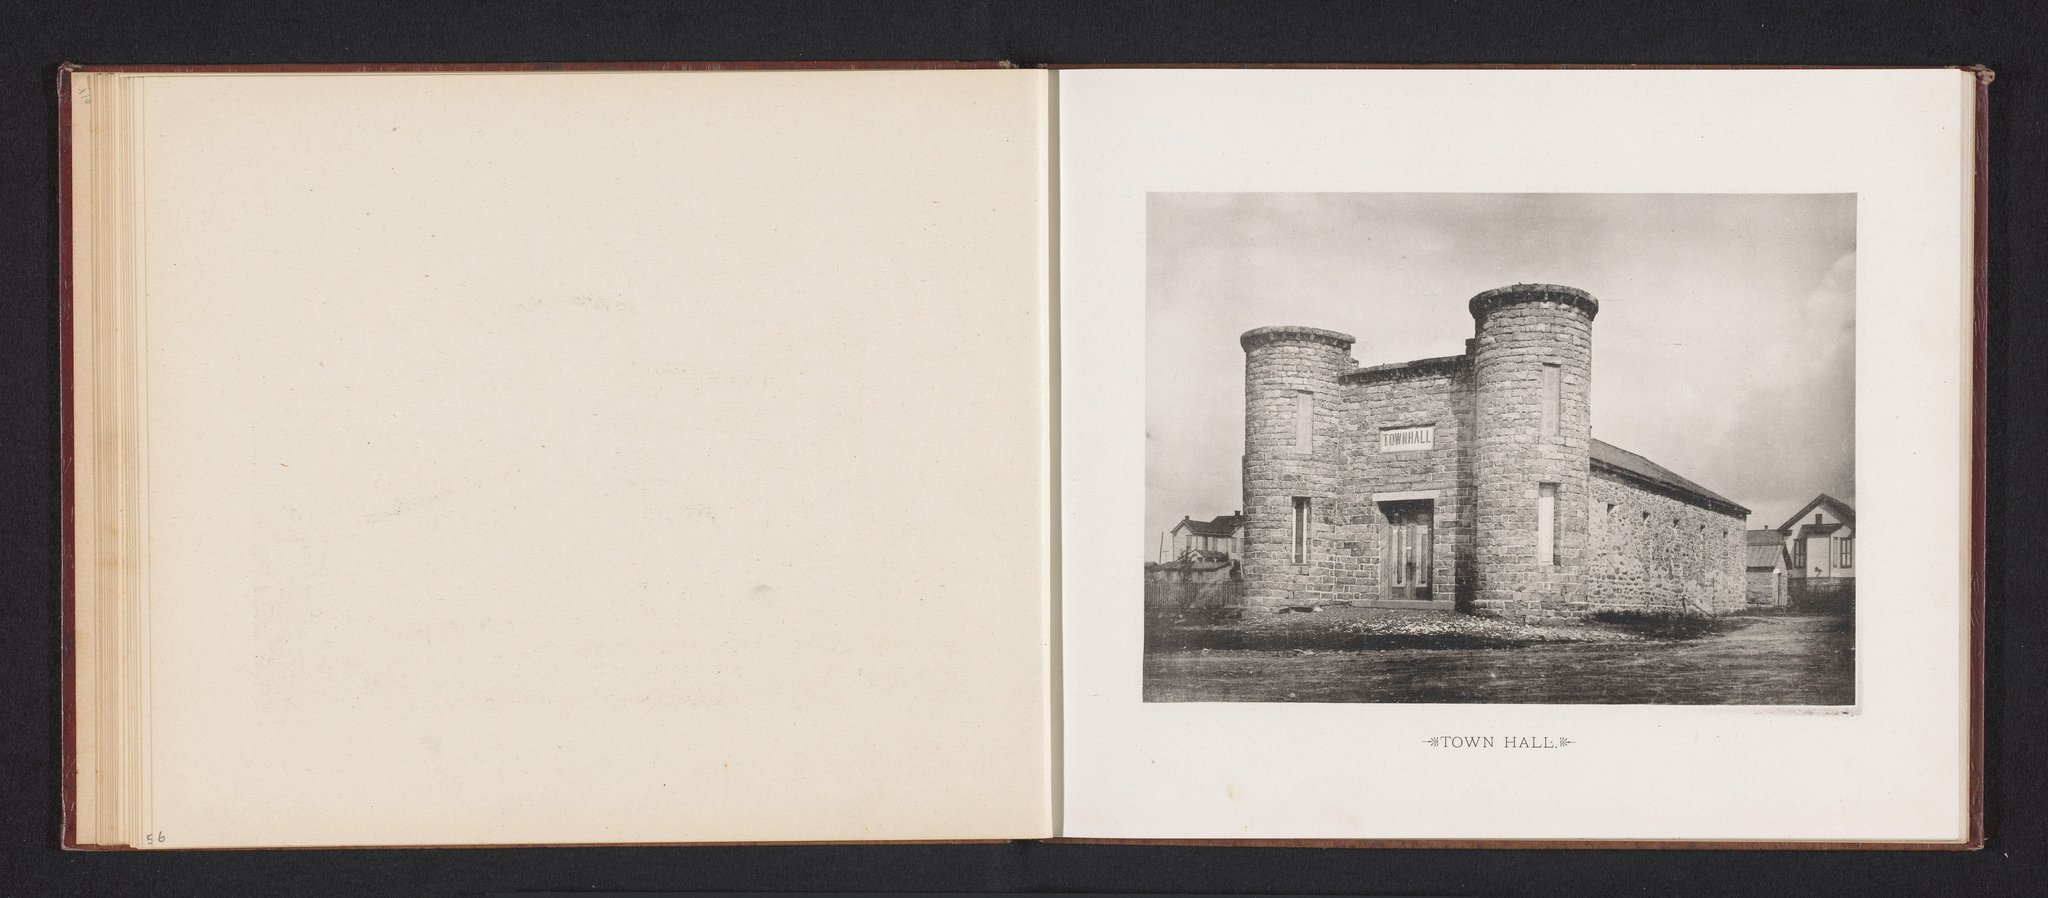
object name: page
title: Town Hall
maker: Anonymous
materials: paper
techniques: photograph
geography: summit hill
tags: townhall